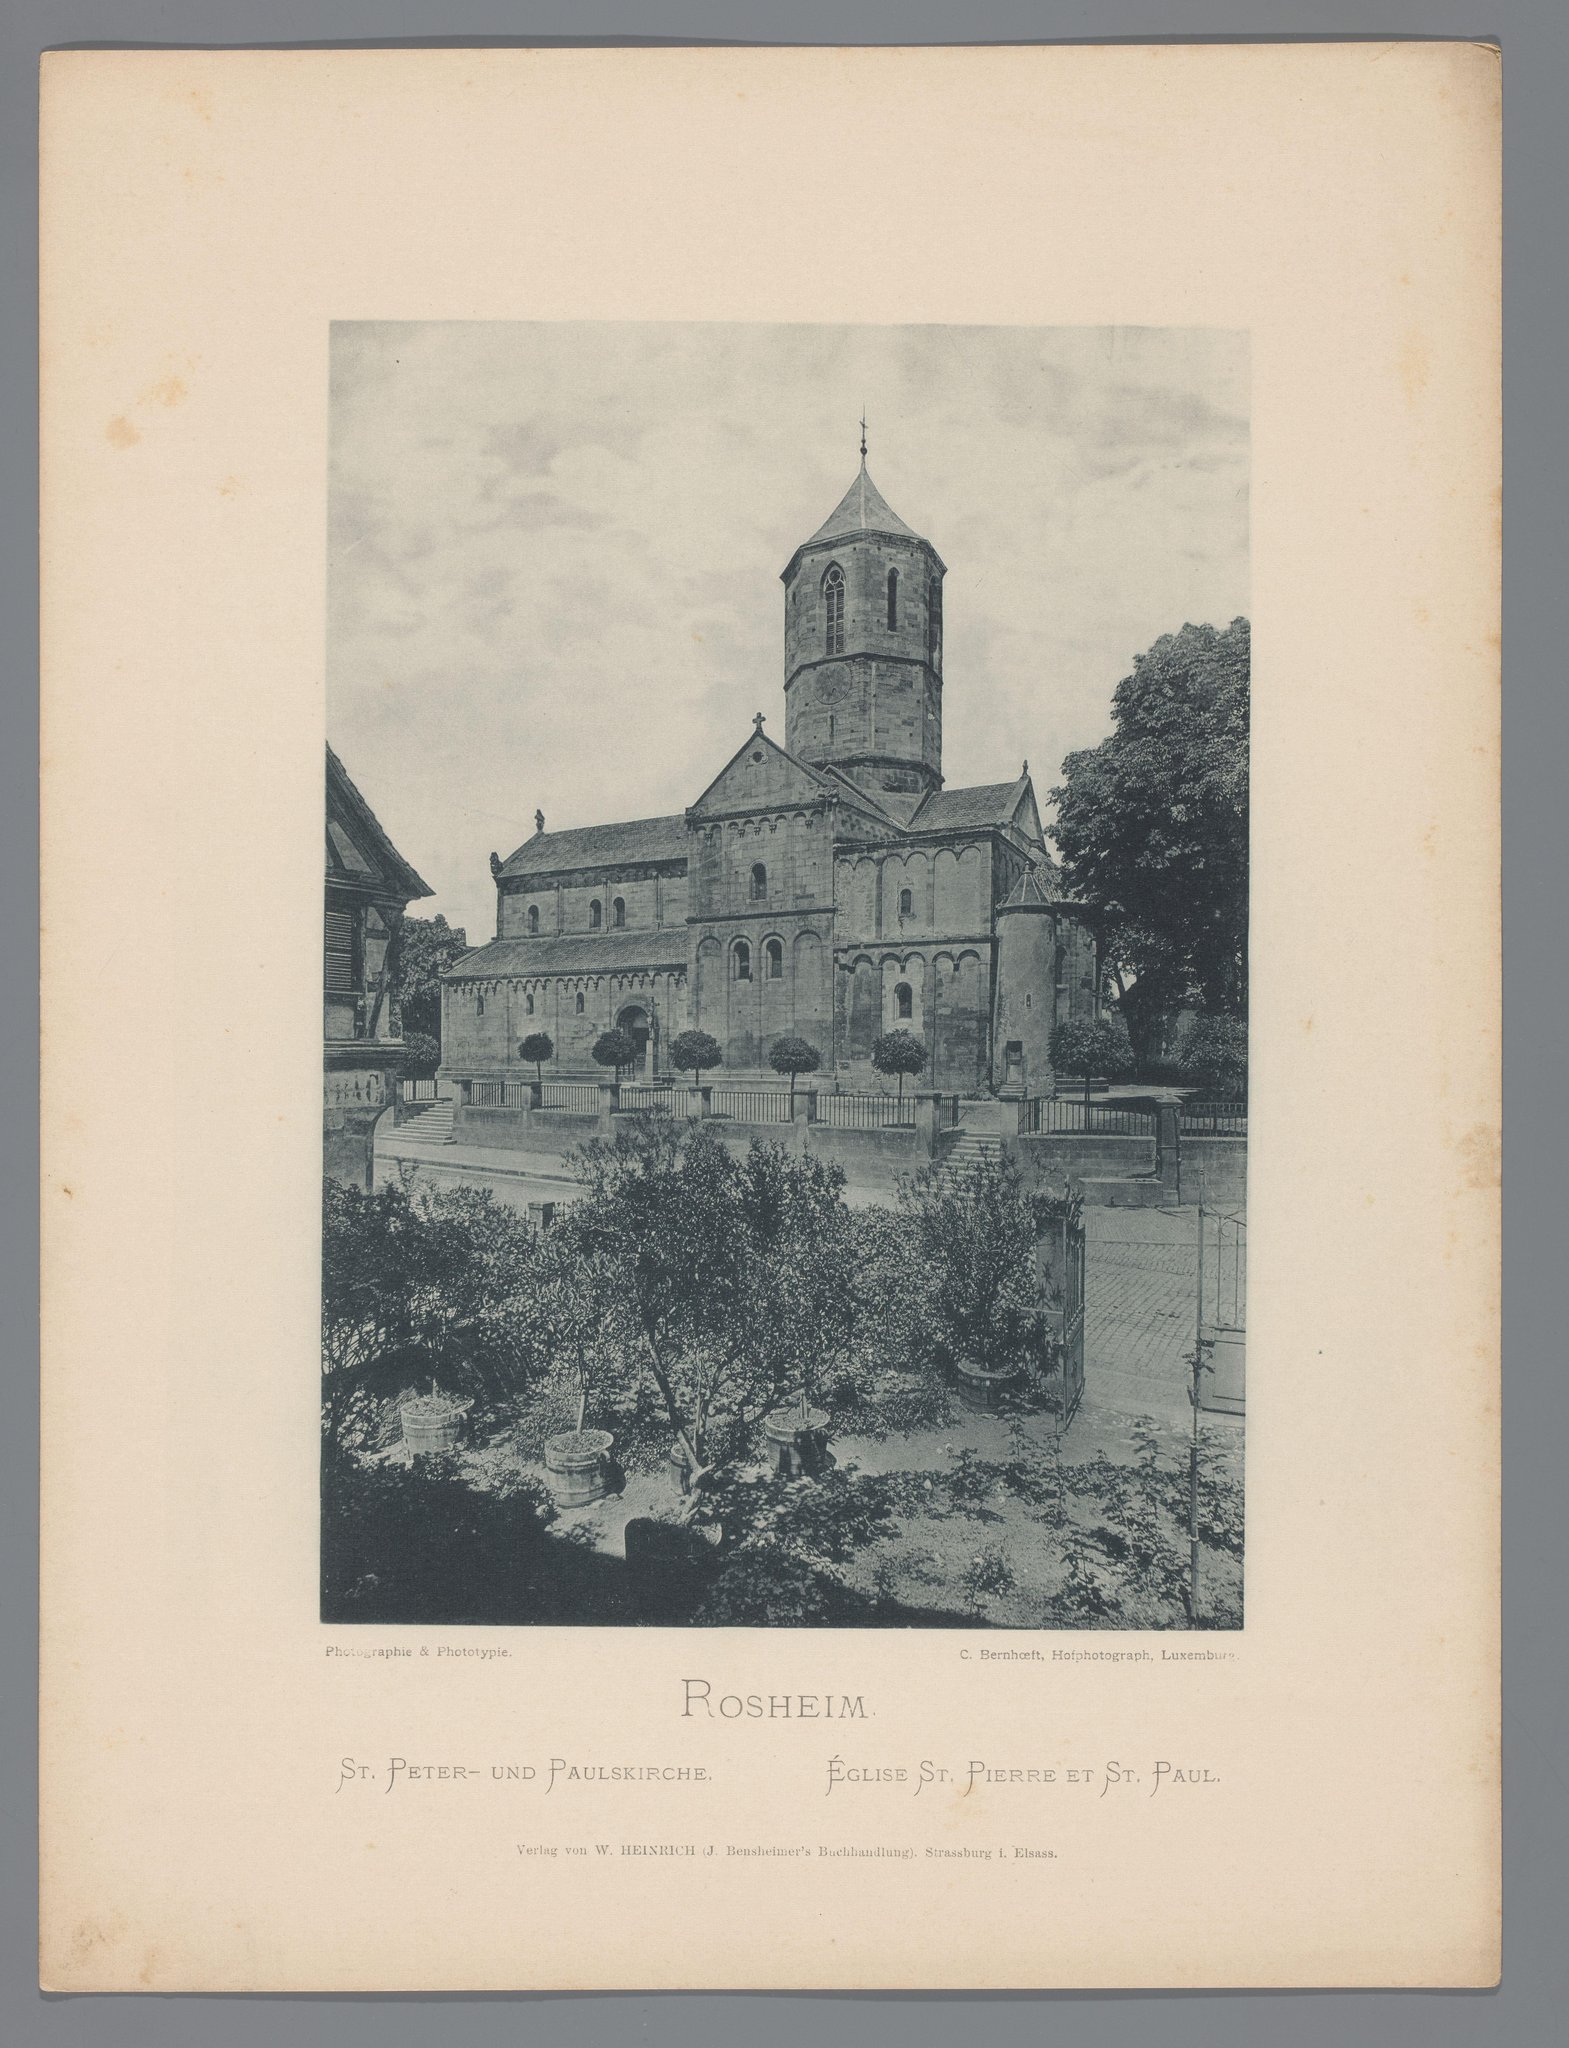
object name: page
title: Gezicht op de Sint-Petrus-en-Pauluskerk te Rosheim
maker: charles bernhoeft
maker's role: publisher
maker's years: 1859-1933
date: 1889-1894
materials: paper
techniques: photograph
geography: rosheim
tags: church (exterior)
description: Deze prent maakt deel uit van een omslag met 100 prenten.